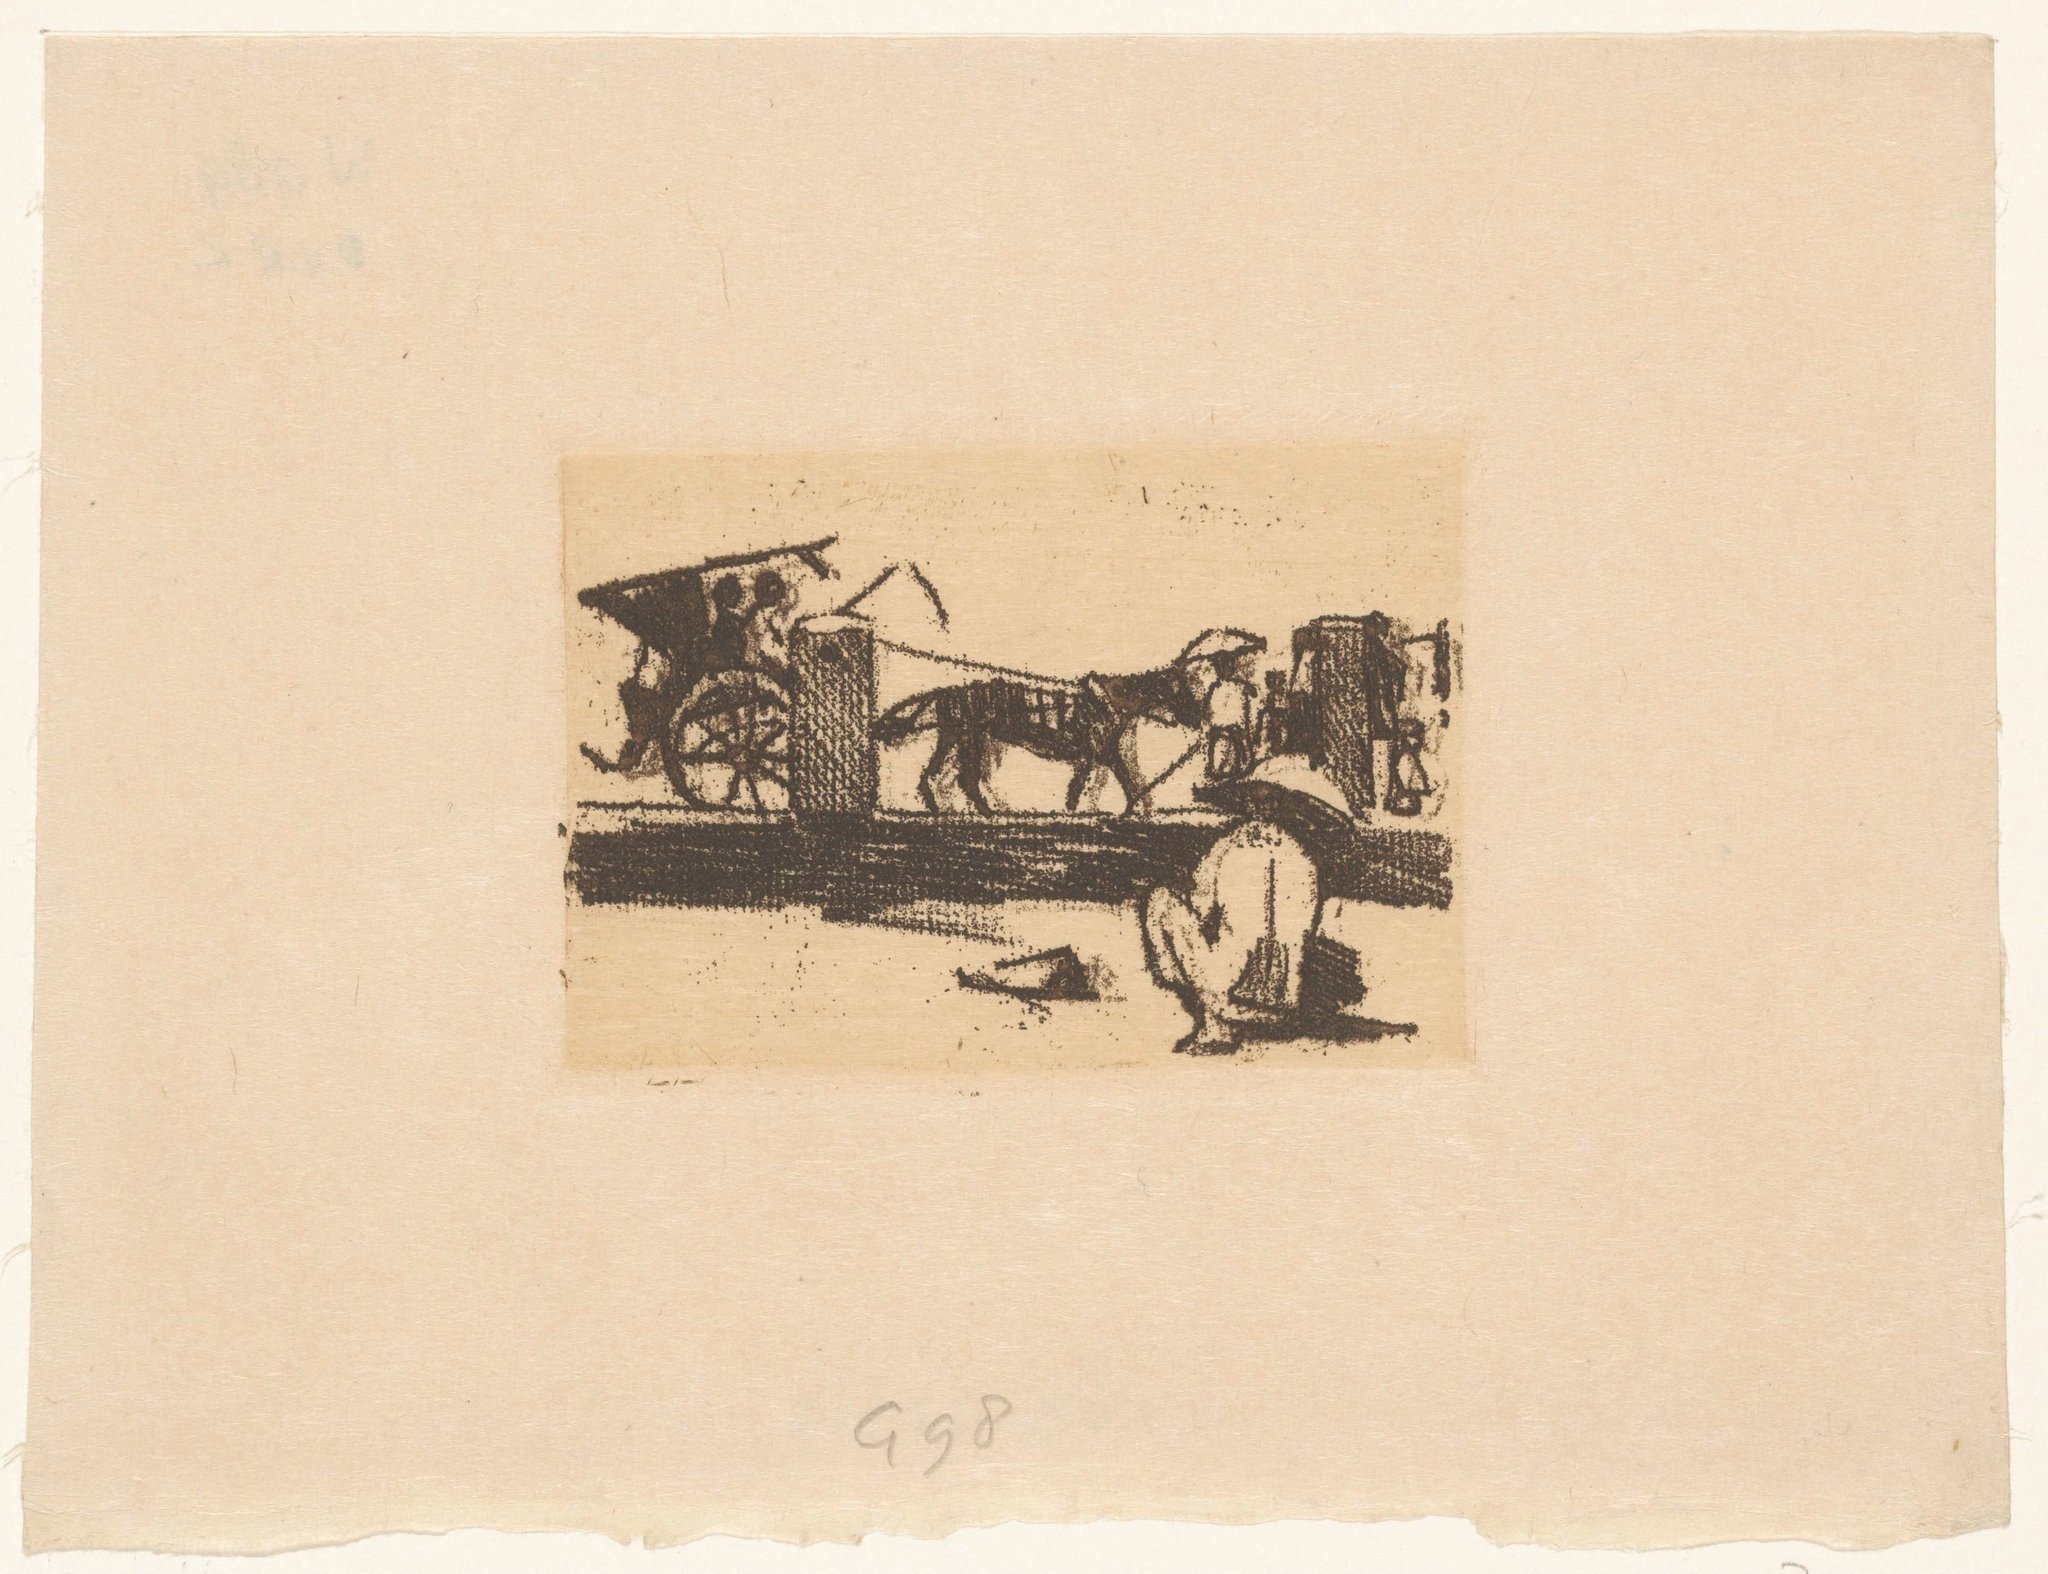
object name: print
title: Hurkend figuur en een sado in Buitenzorg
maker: willem witsen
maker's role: draughtsman, painter, print maker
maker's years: 1860-1923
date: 1921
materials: paper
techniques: soft ground etching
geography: amsterdam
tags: two-wheeled, animal-drawn vehicle, squatting, crouching figure